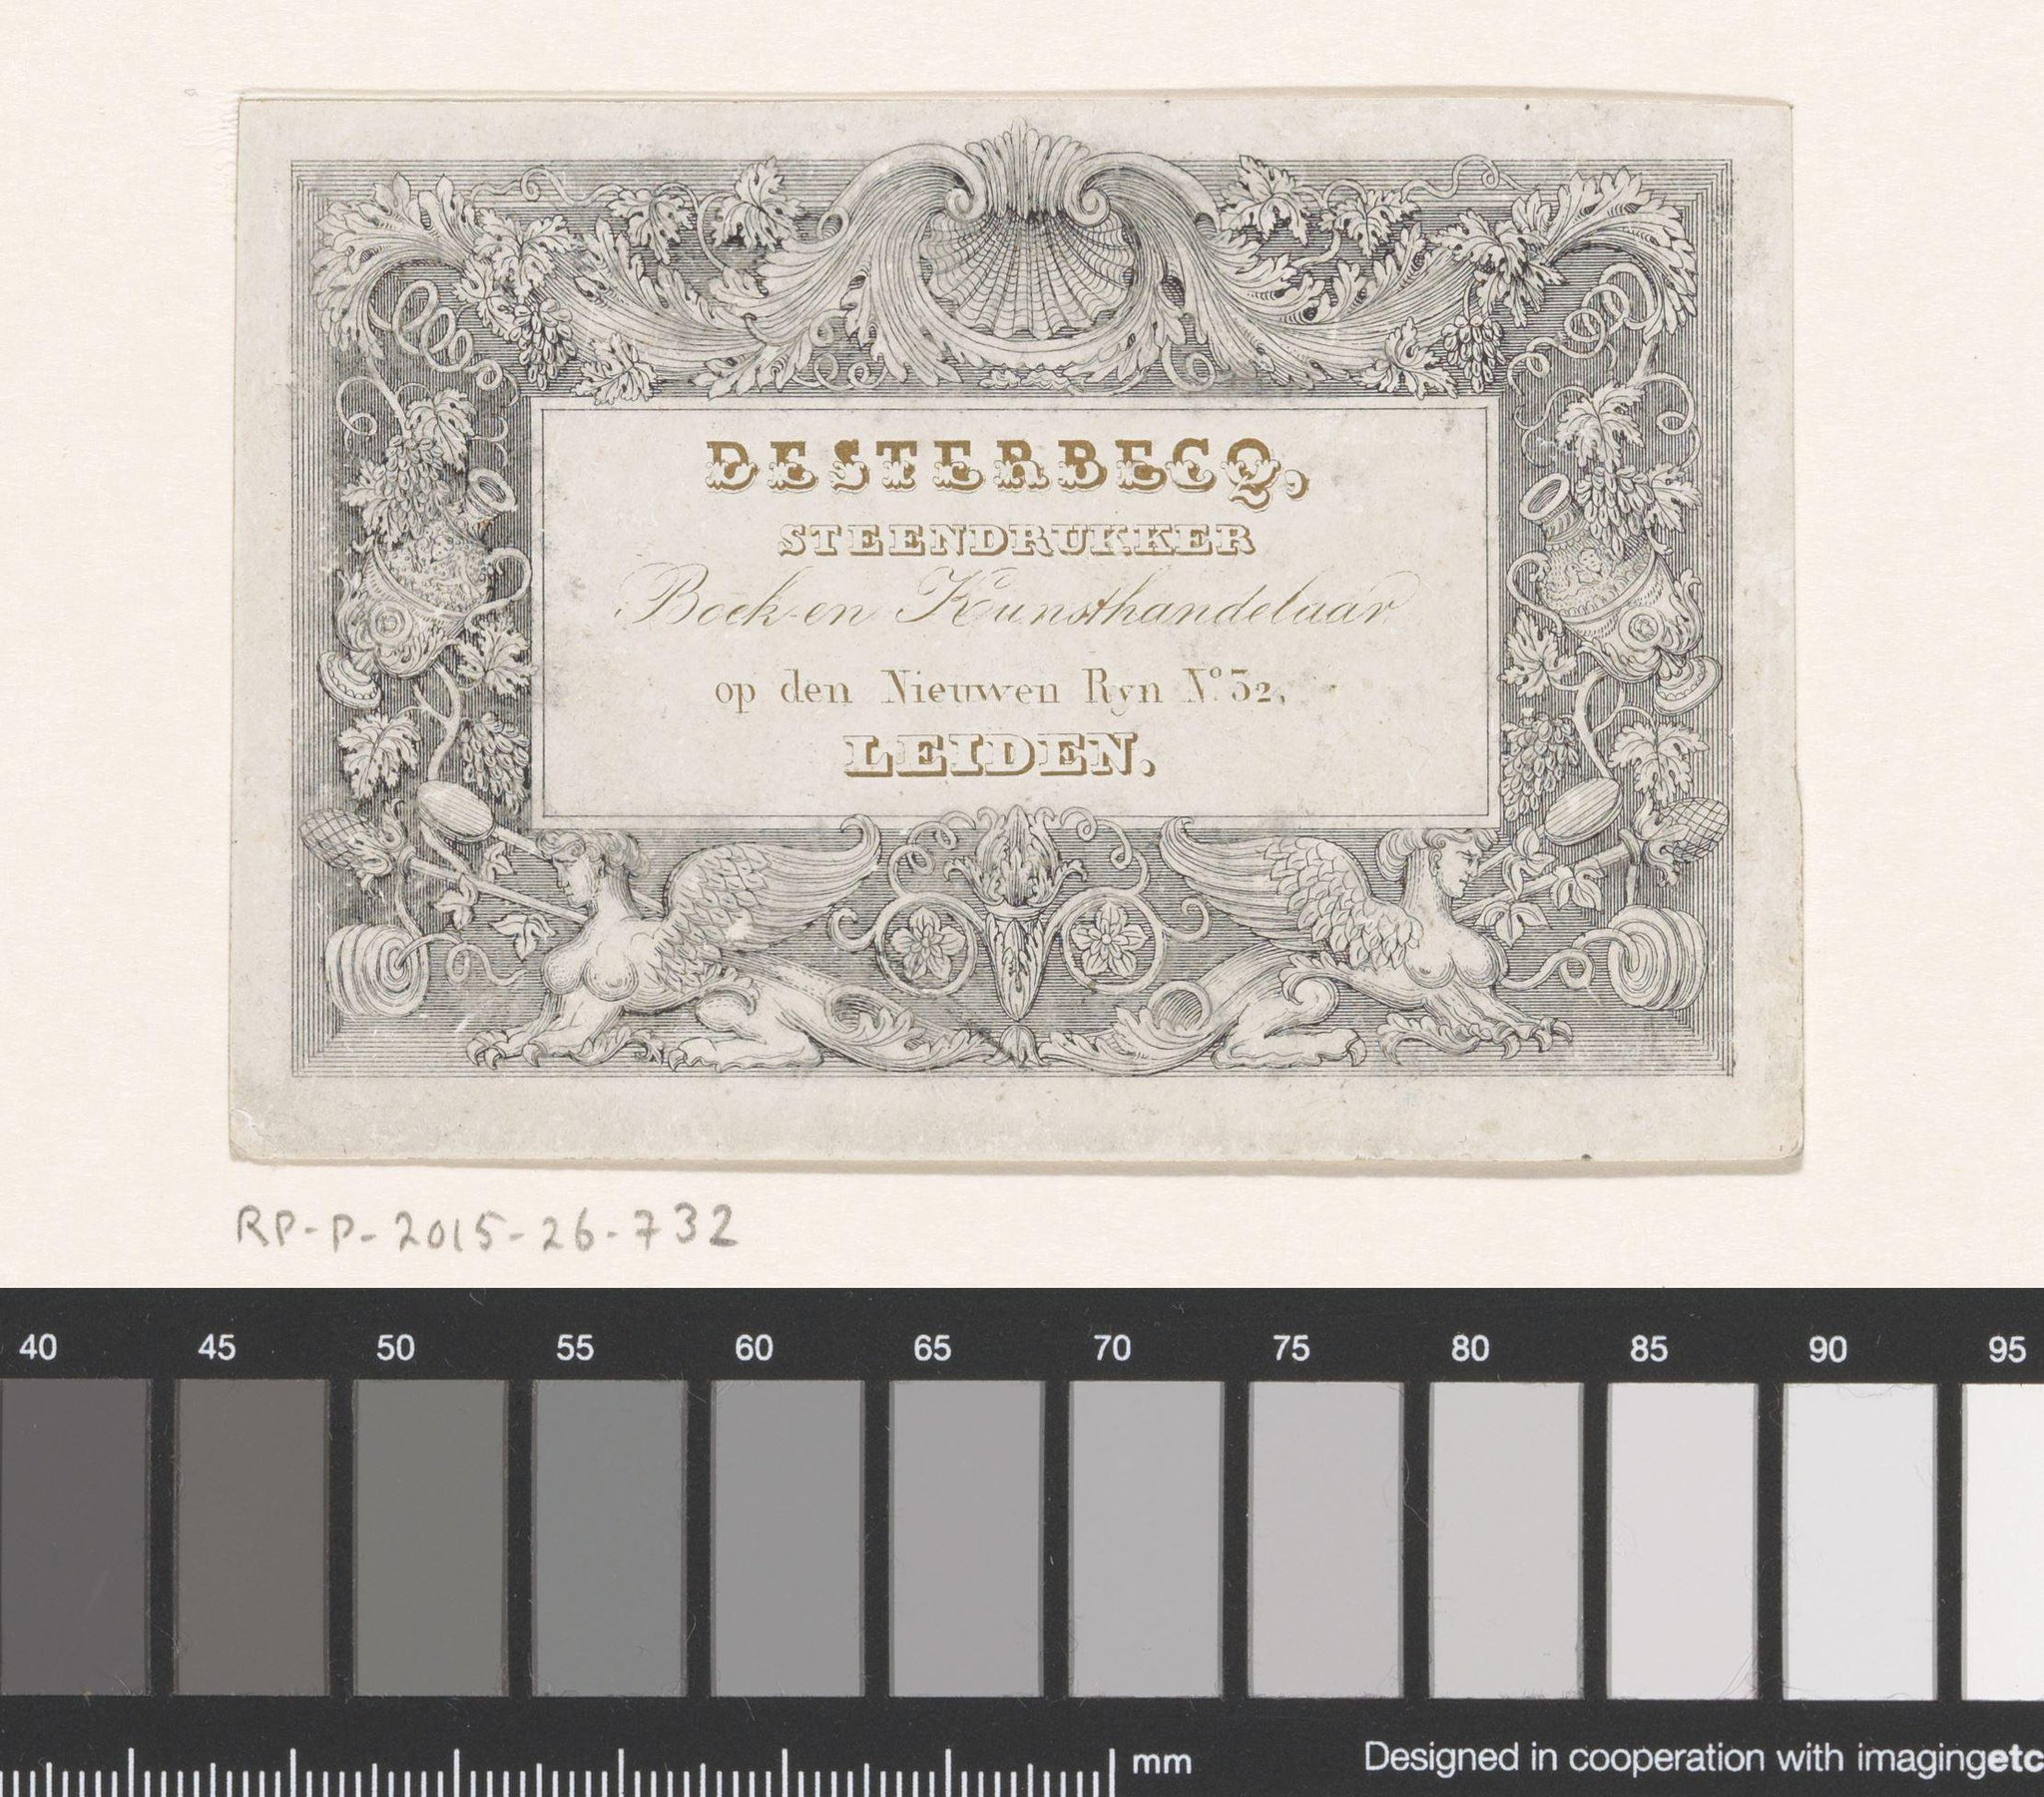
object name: print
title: Visitekaartje van steendrukker François Desterbecq te Leiden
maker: françois desterbecq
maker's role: print maker, printer, publisher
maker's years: 1807-1896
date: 1831-1839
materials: porcelainized cardboard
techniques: lithograph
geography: leiden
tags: sphinx (lion/woman); 'sfinge' (ripa) - aa - female human figure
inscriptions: collector's mark: Lugt 2228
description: Omlijsting met wijnranken, twee amfora's en twee sfinxen.